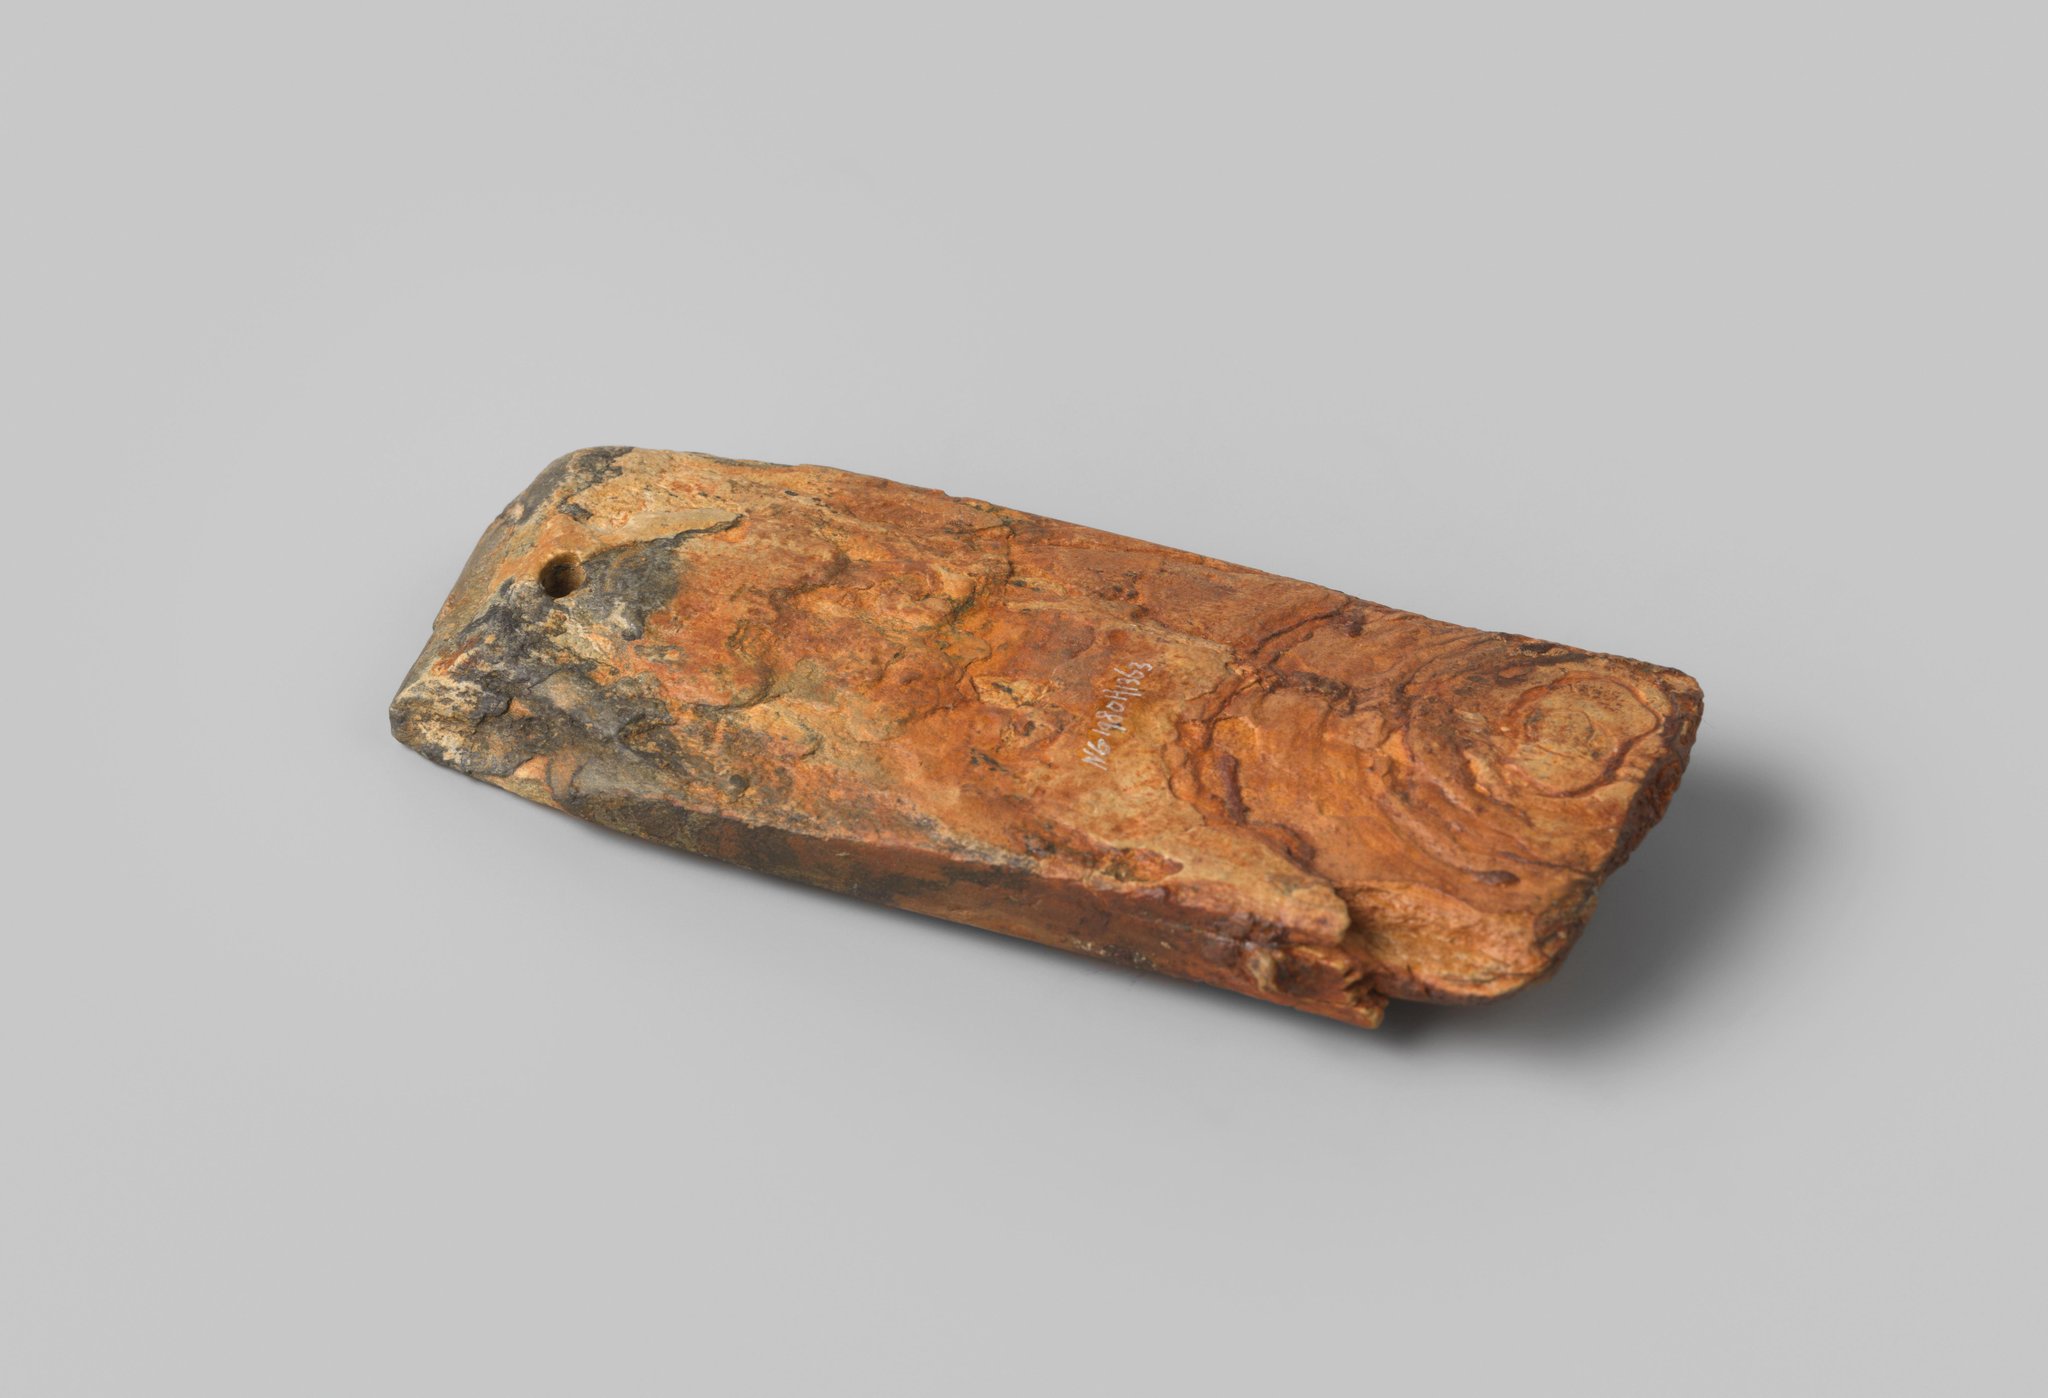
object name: whetstone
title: Slijpsteen uit het wrak van de Oost-Indiëvaarder Hollandia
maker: Anonymous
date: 1700-1743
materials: stone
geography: netherlands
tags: verenigde oostindische compagnie, hollandia (schip), annet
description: Hone; fragm, one end broken: split longitudinally, flat underside, rectangular in section, rounded end with circular hole.